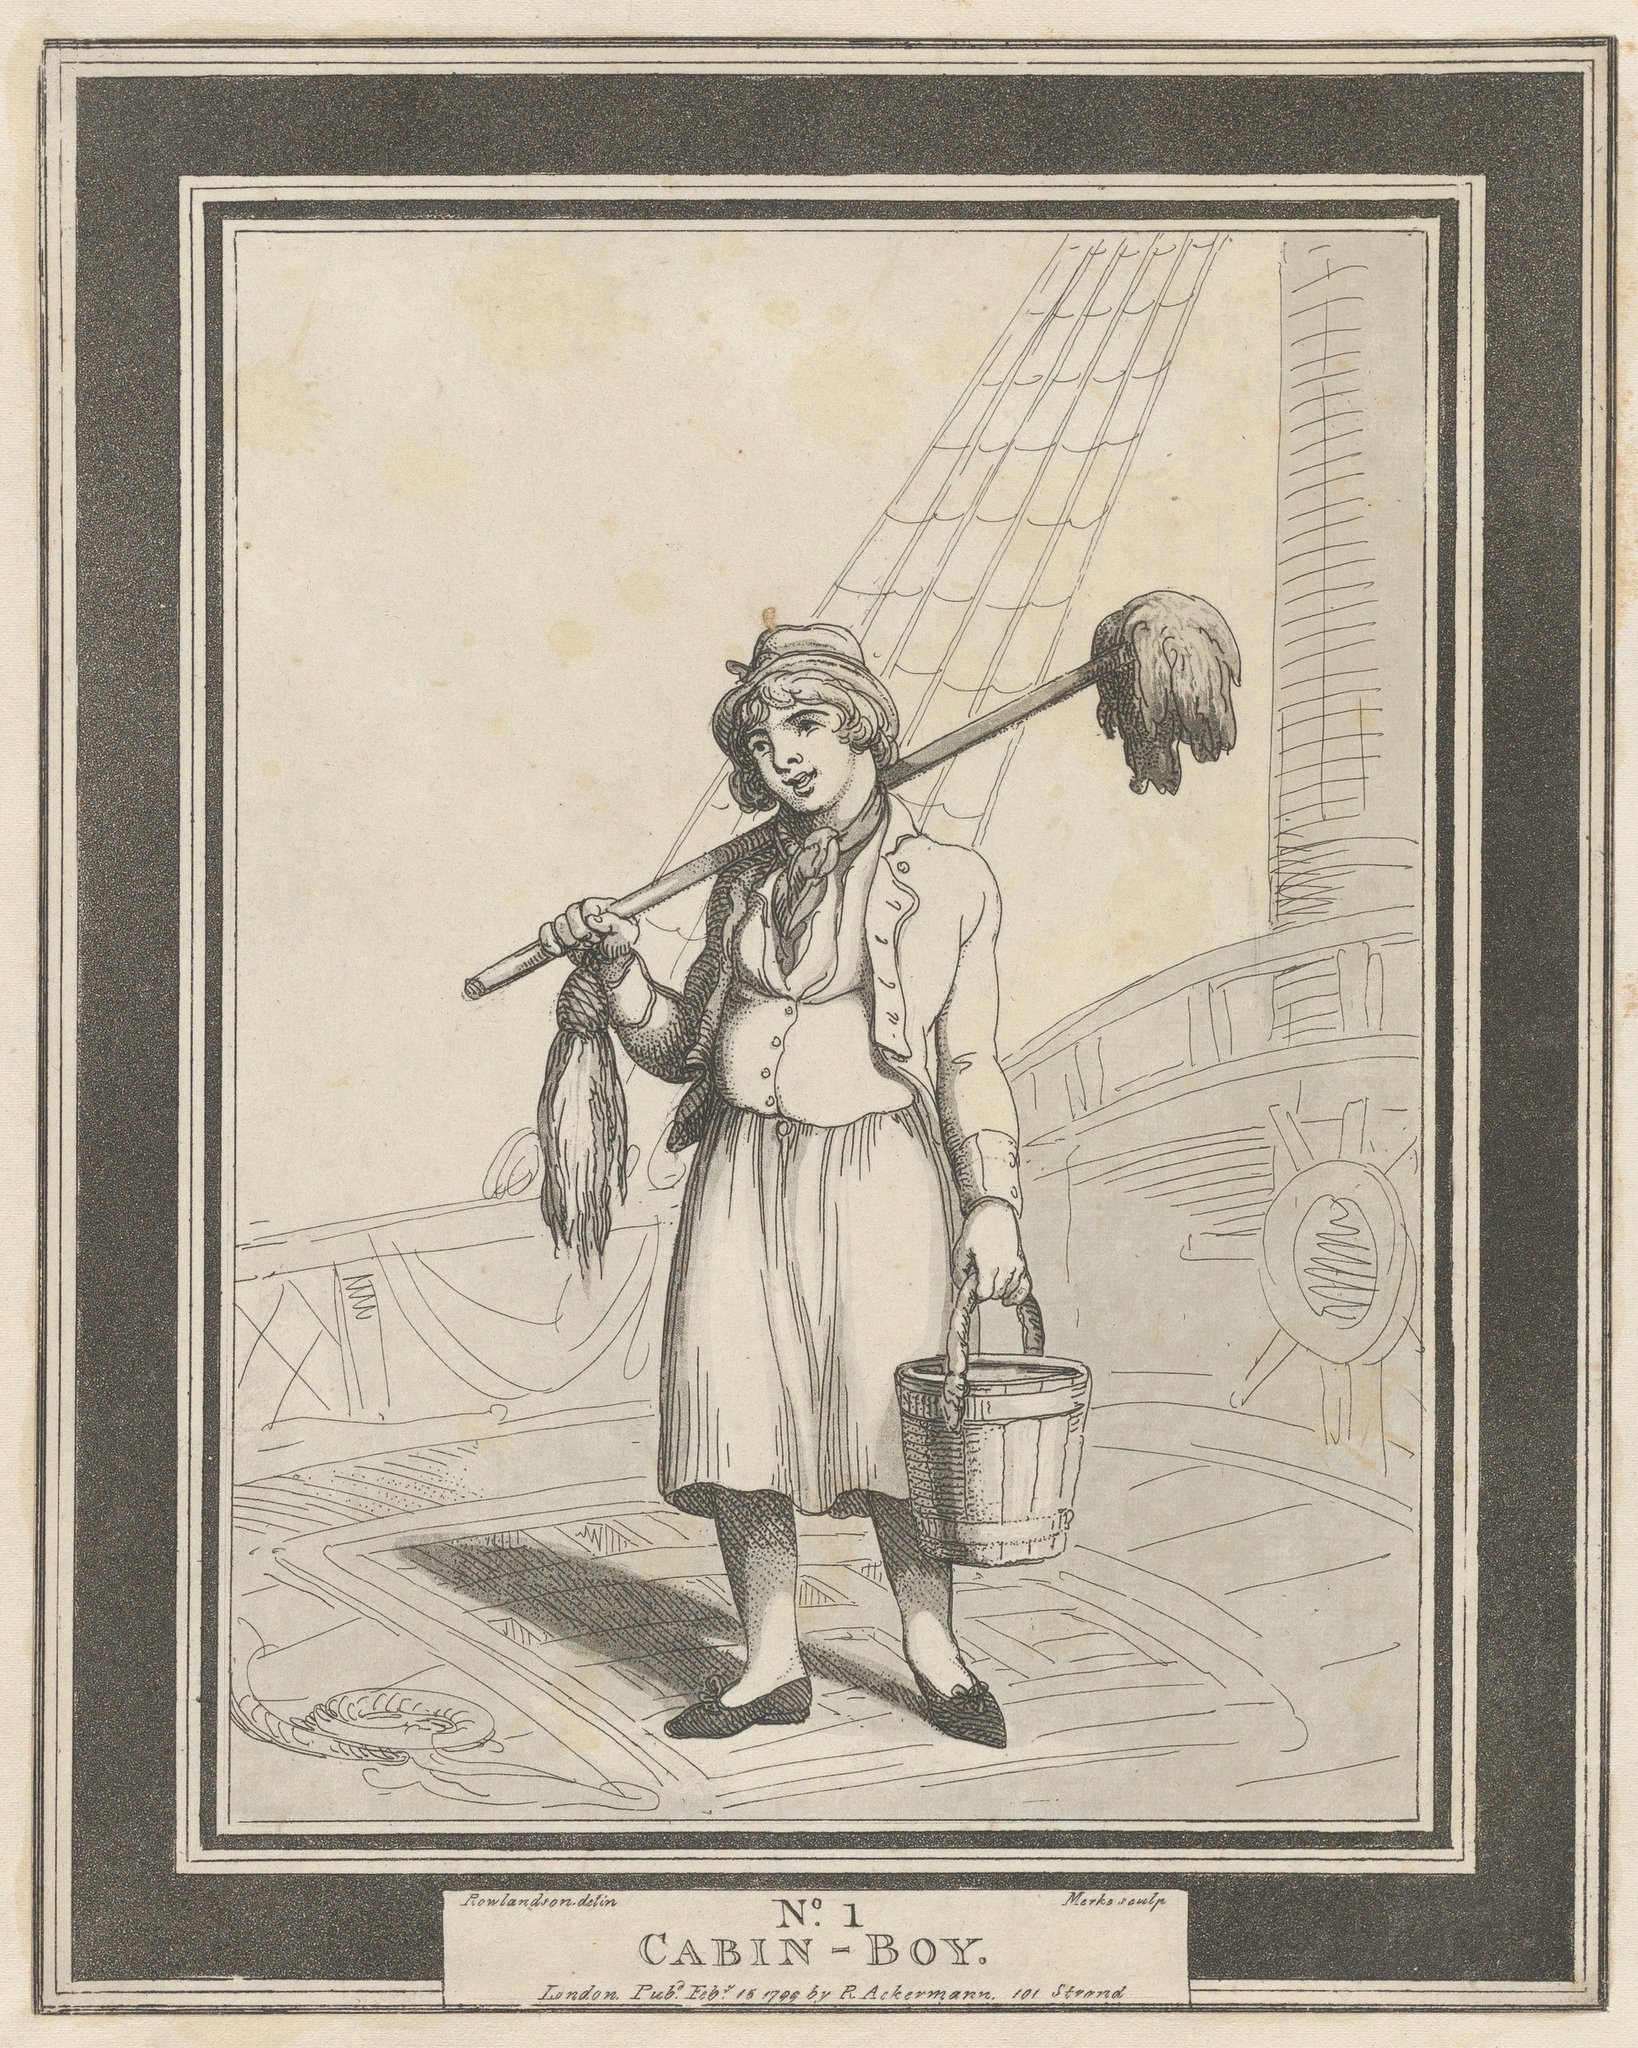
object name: print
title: No. 1: Cabin Boy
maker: henri merke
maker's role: etcher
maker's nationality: swiss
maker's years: 1760-1820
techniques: aquatint, etching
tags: boys